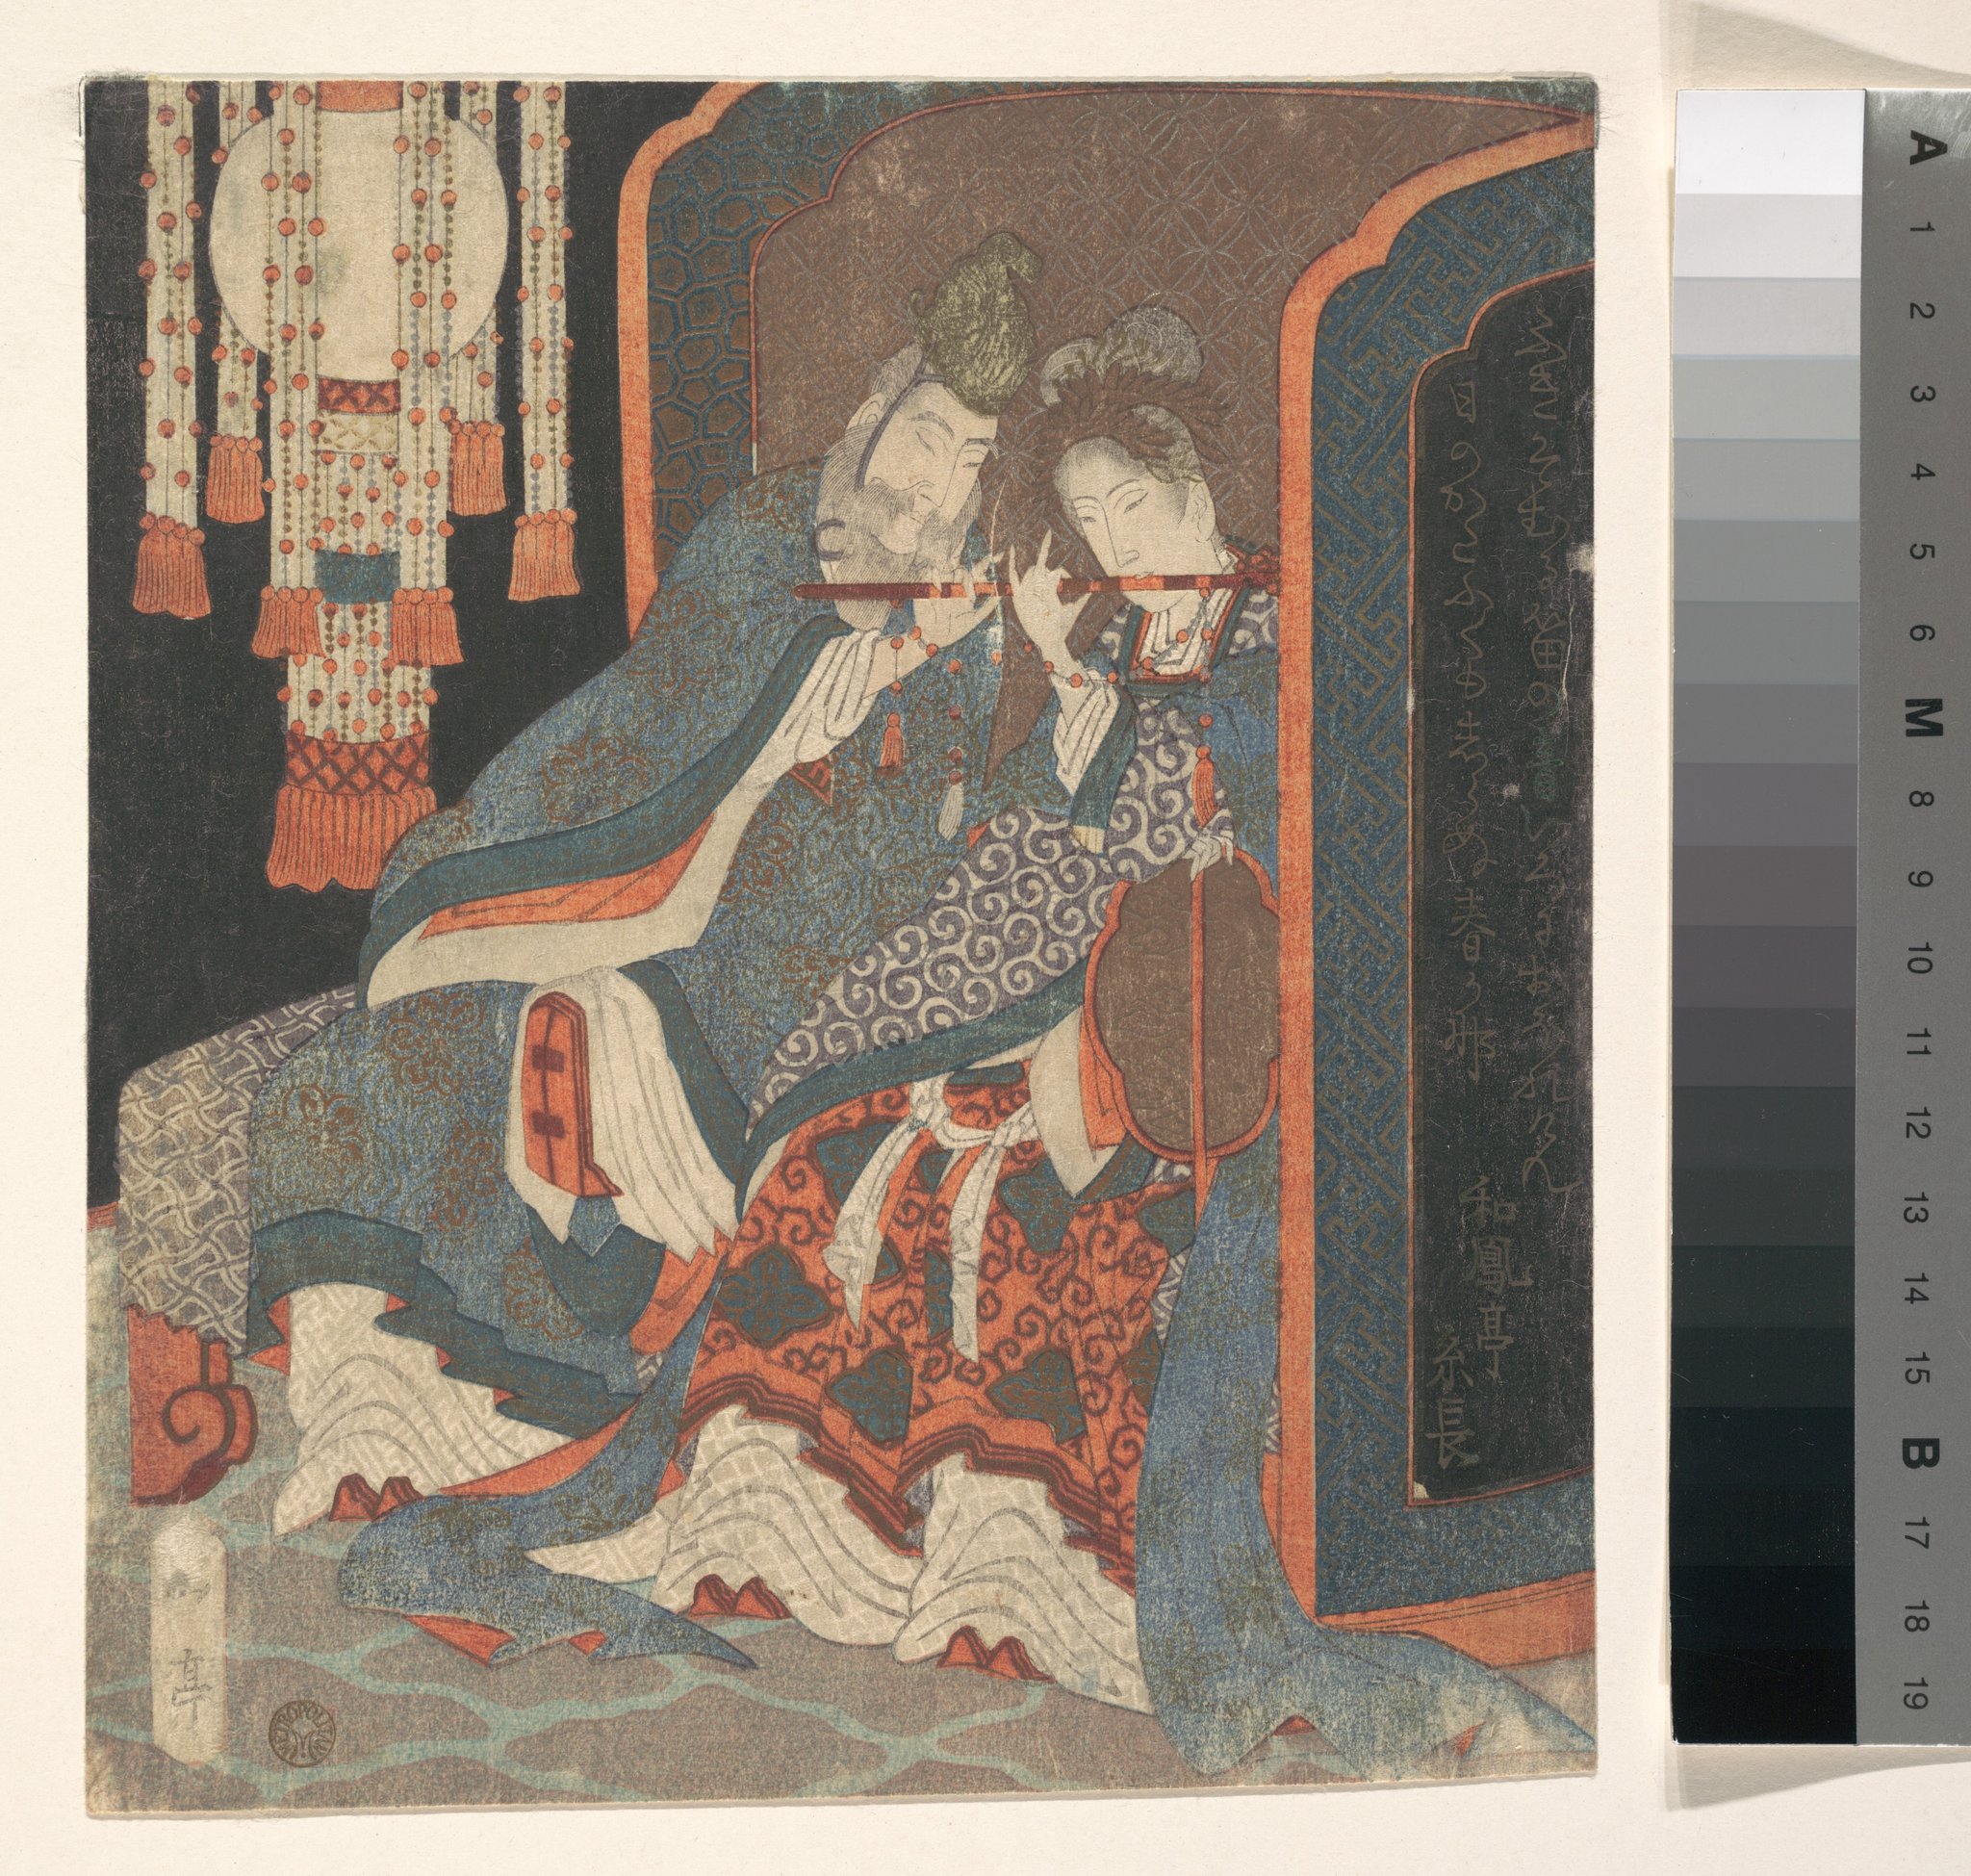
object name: print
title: Genso and Yokihi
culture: japanese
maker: yashima gakutei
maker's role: artist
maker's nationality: japanese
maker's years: 1786-1868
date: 1820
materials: ink, paper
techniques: surimono, woodblock print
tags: men,women,flutes